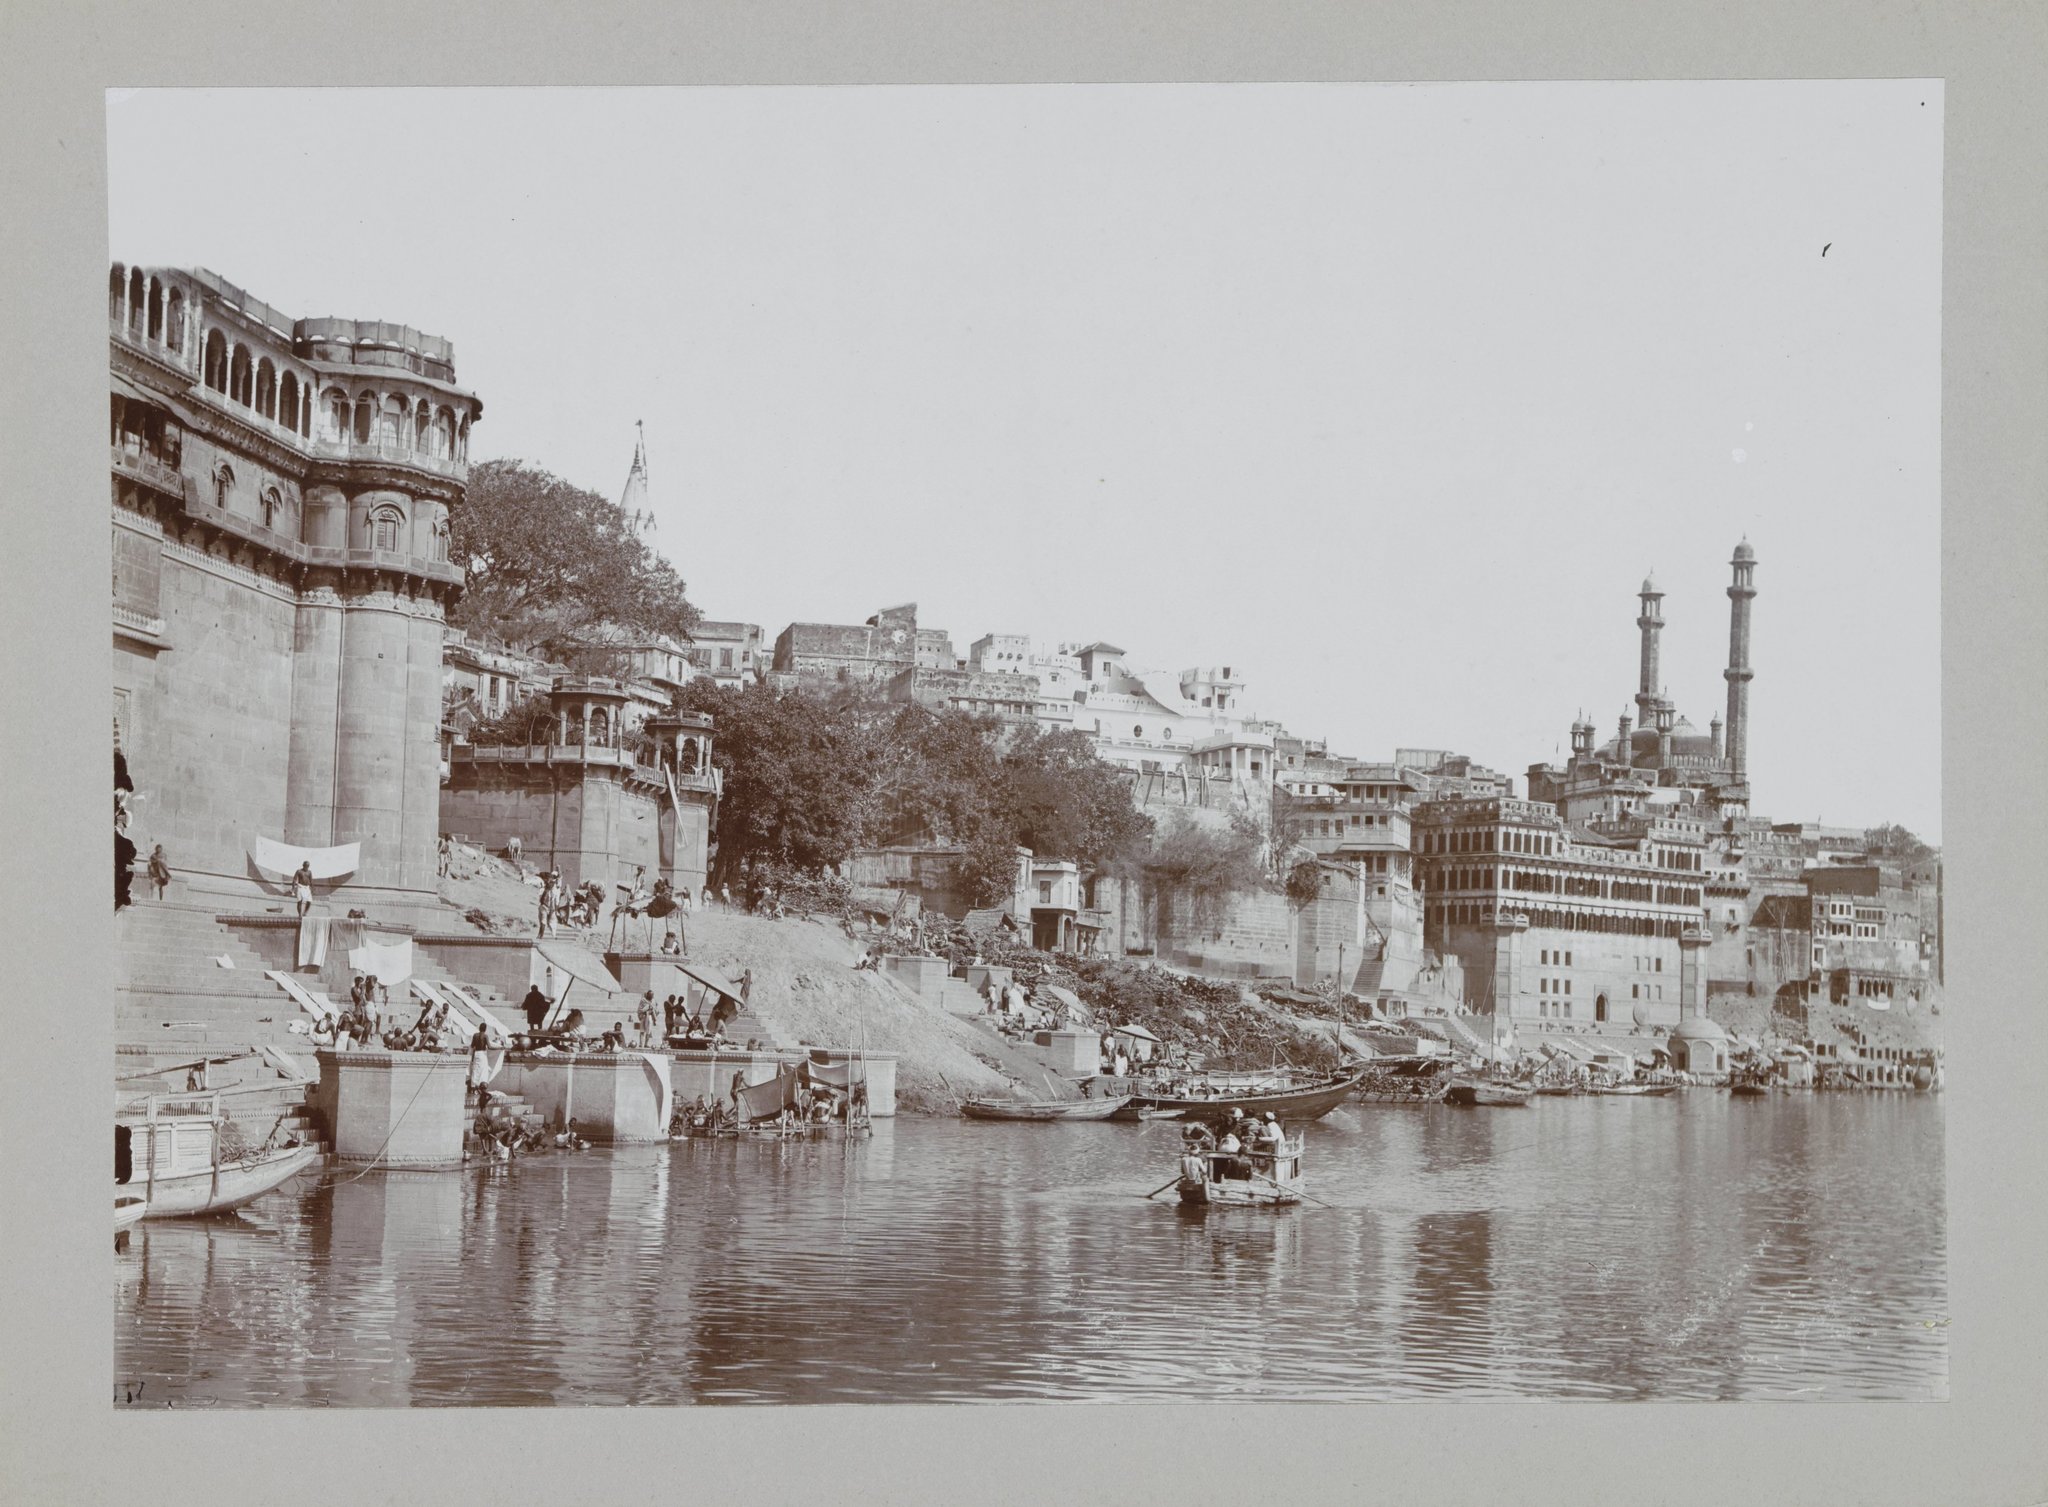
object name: photograph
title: View of the Ganga river at Varanasi, Uttar Pradesh, India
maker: Anonymous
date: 1895-1915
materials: cardboard, paper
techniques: gelatin silver print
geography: varanasi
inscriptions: annotation: ‘9. Benares.’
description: Midden onder vaart een bootje op de Ganges.